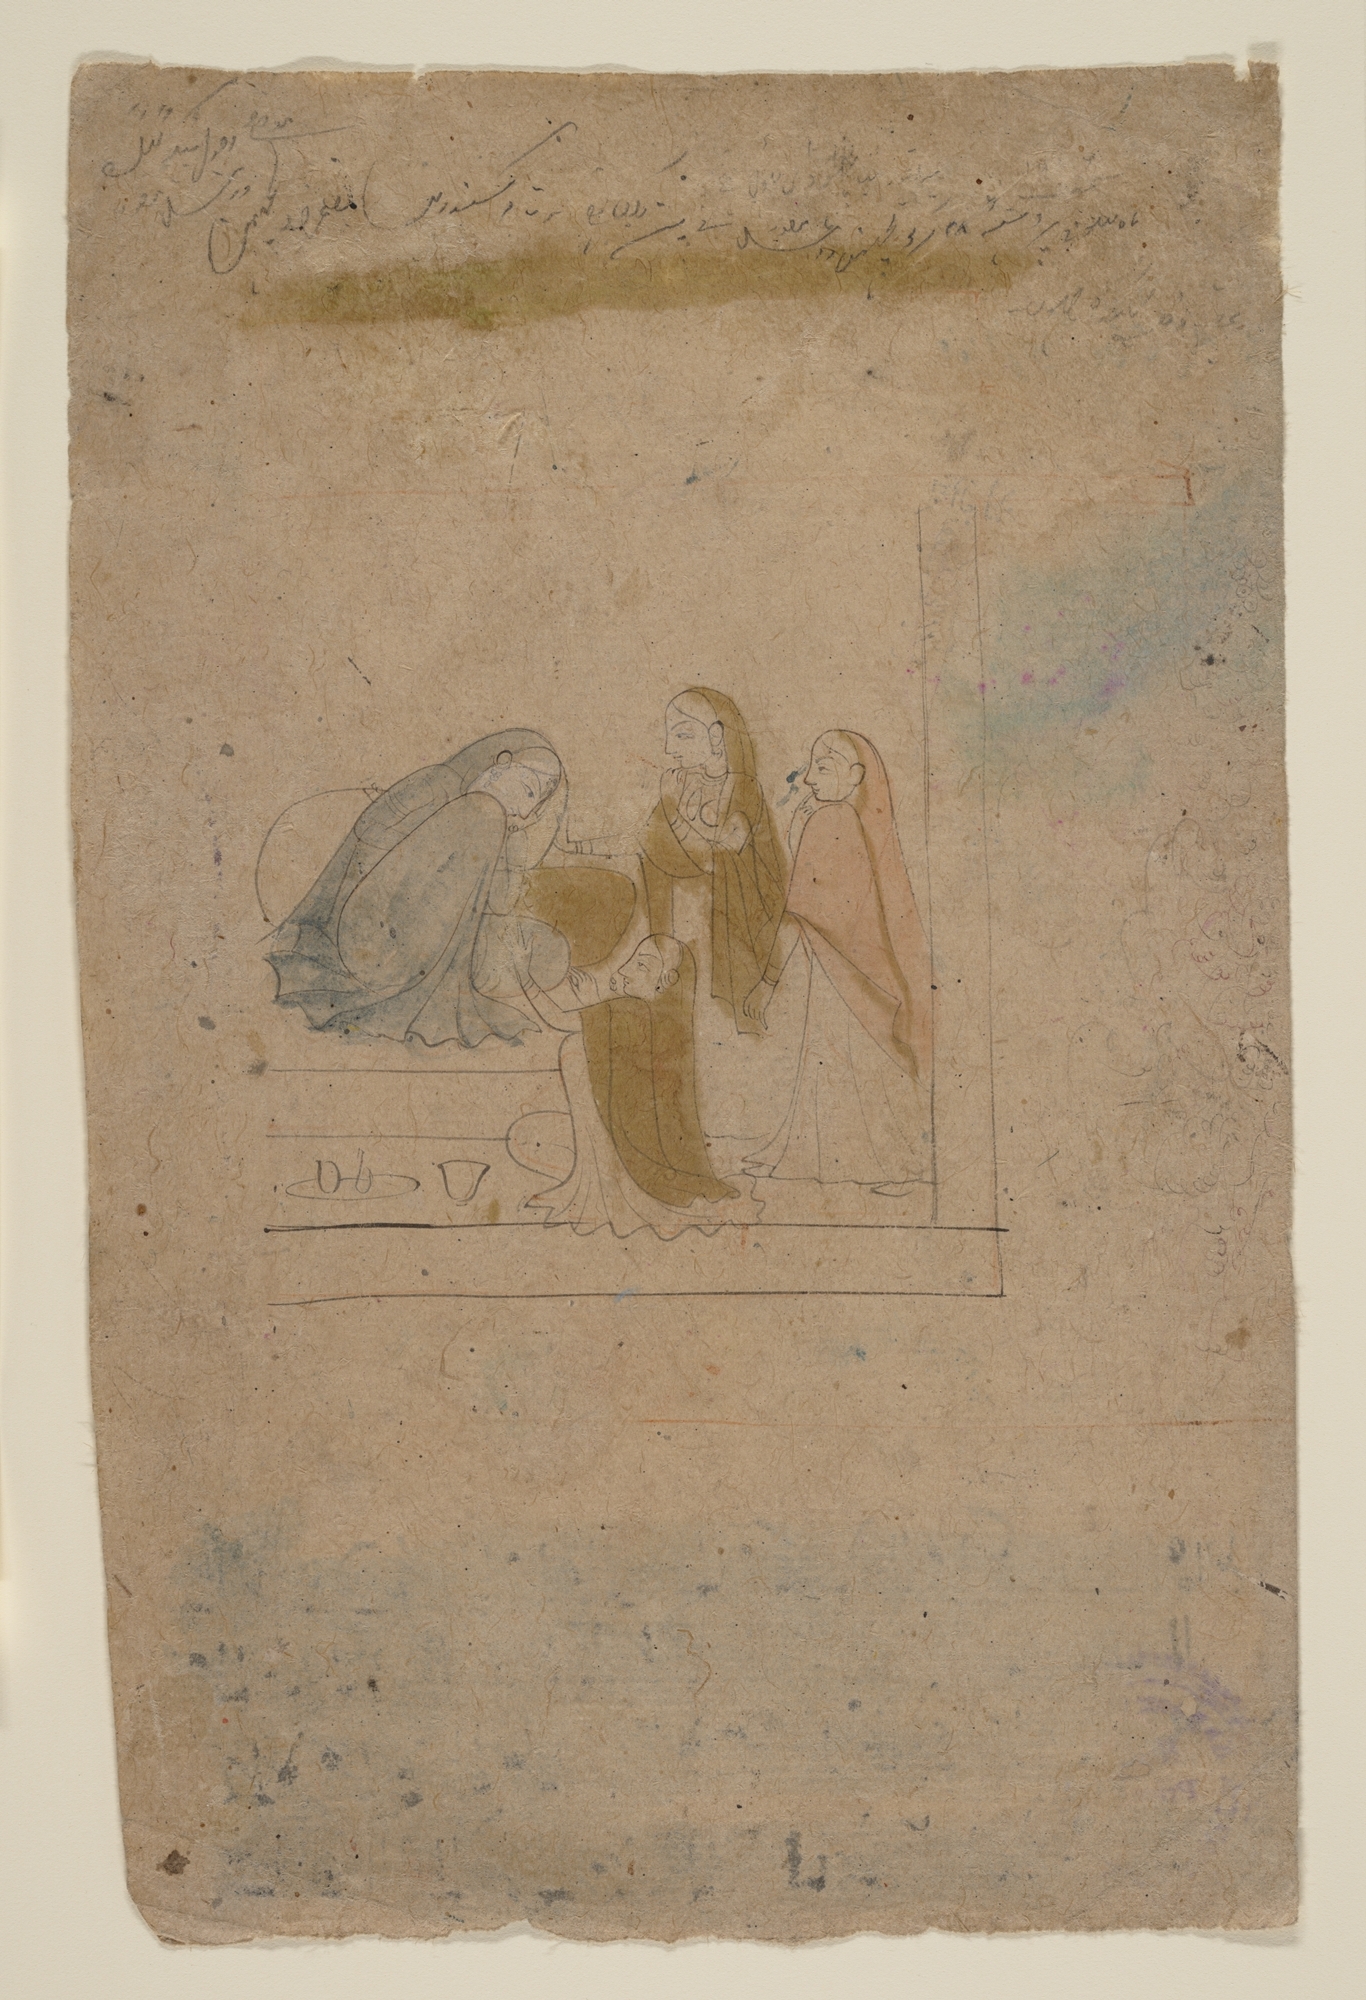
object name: painting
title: A Lady with Attendants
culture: india, pahari hills, kangra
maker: nainsukh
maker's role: artist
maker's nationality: indian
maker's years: 1725-1778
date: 1775-1780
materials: ink, paper, watercolor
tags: women